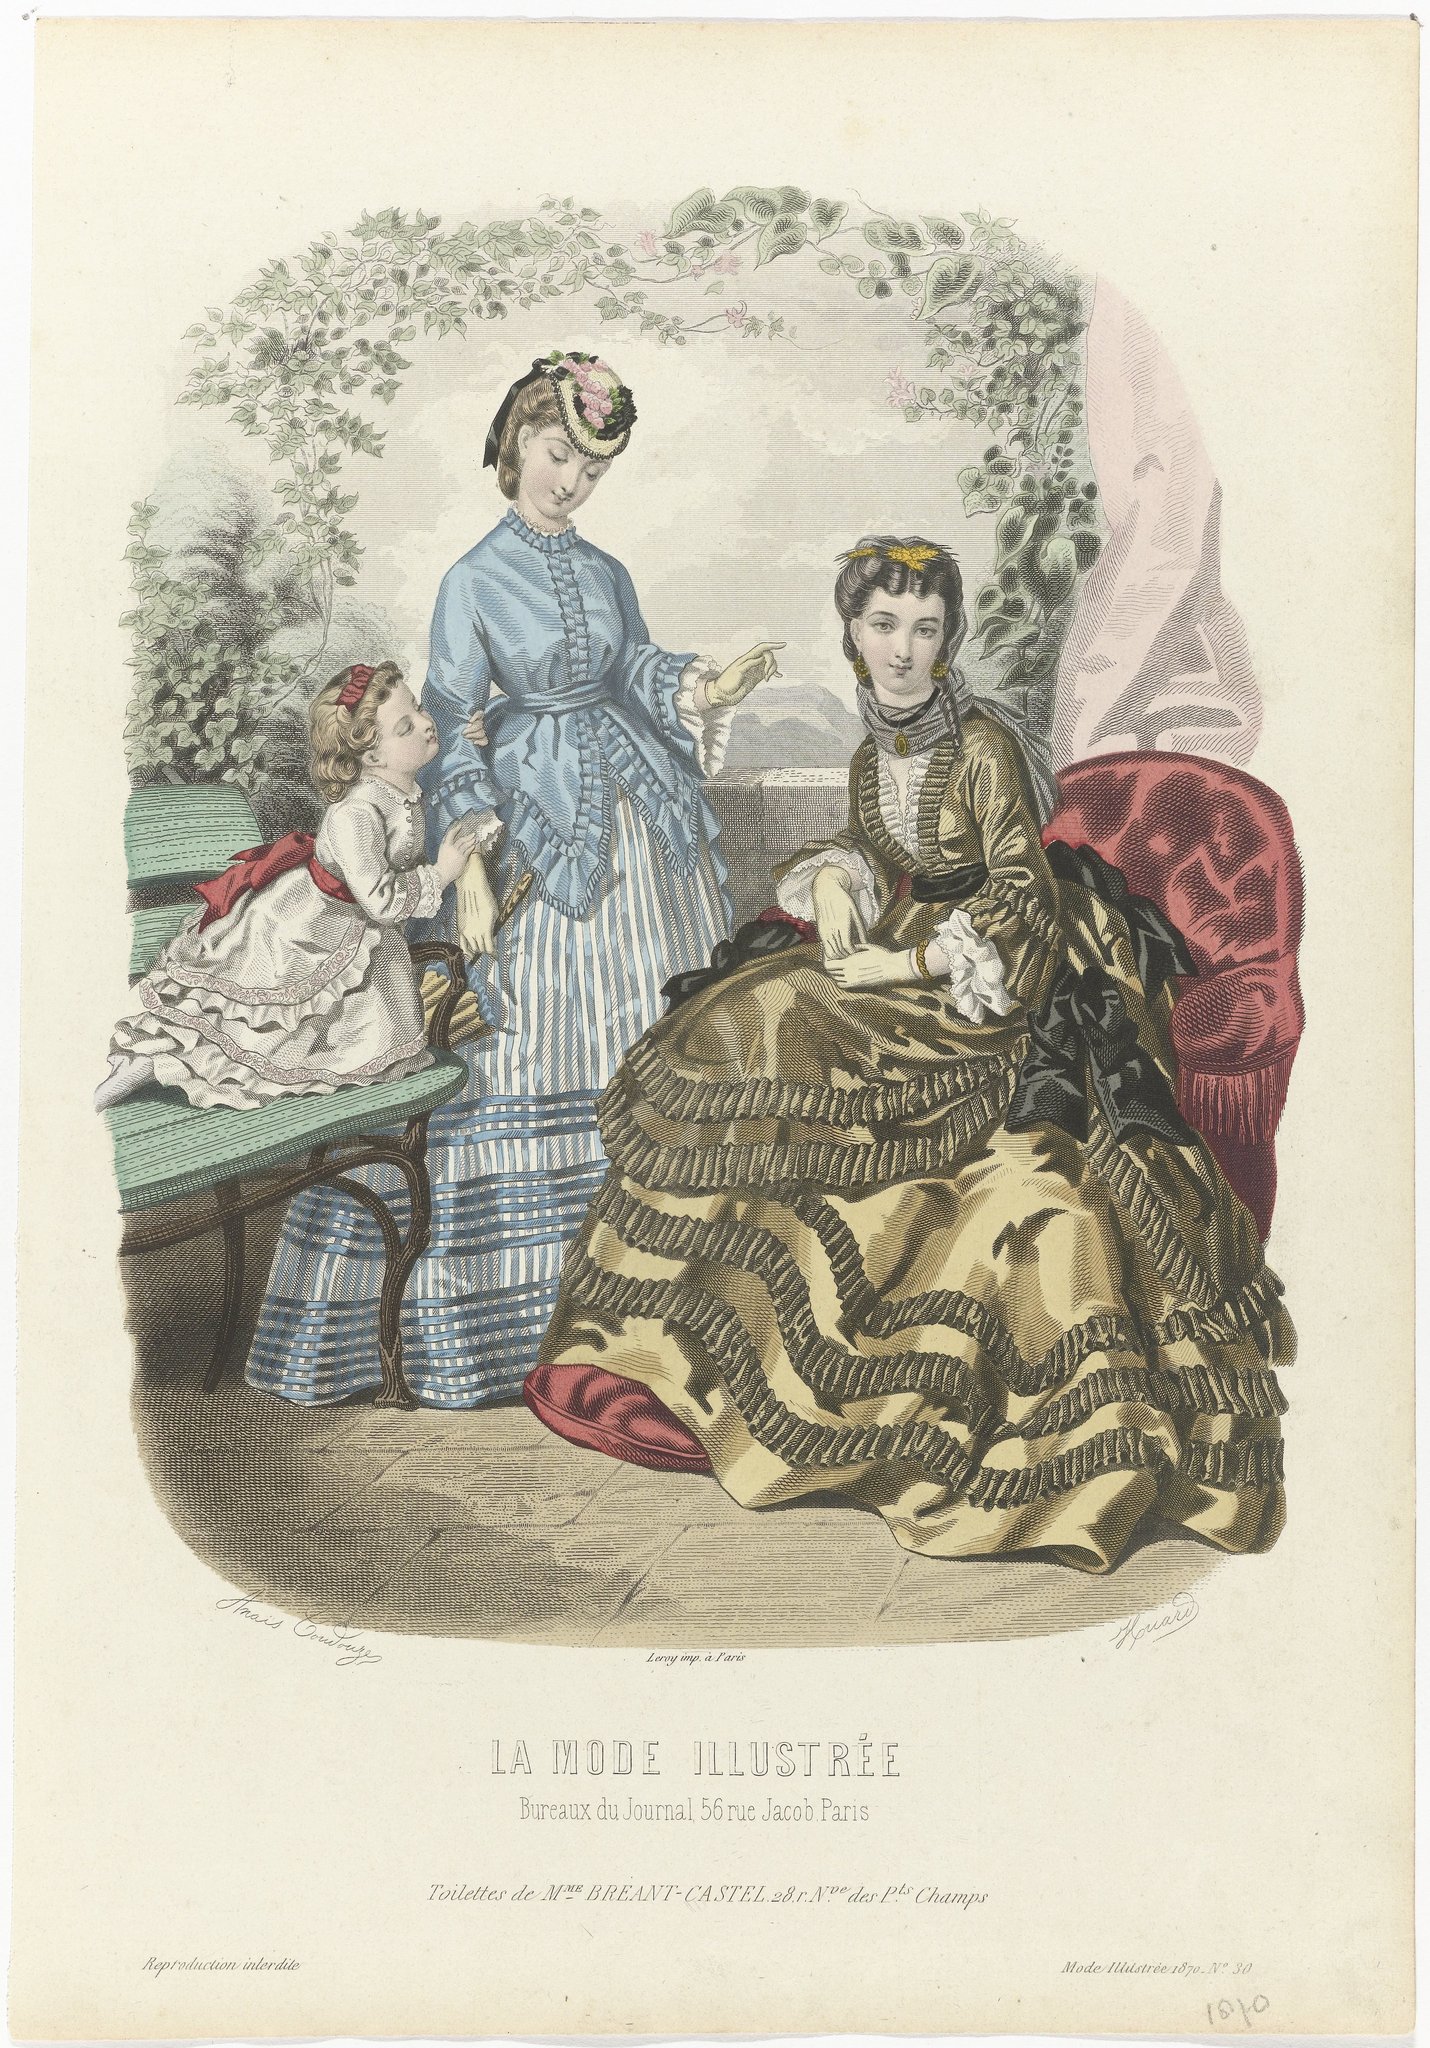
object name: fashion print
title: La Mode Illustrée, 1870, No. 30: Toilettes de Mme Breant-Castel (...)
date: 1870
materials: paper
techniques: engraving, hand coloring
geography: paris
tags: clothing for the upper part of the body (+ women's clothes), pendant, trinket, 'breloque' (+ women's clothes), belt, girdle, waistband (+ girls' clothes), head-gear (+ women's clothes), fashion plates, skirt (+ women's clothes), gloves, mittens, etc. (+ women's clothes), dress, gown (+ women's clothes), bracelet, wristlet (+ women's clothes), parasol, sunshade (+ women's clothes), dress, gown (+ girls' clothes)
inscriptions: caption: ‘Toilettes de Mme Brèant-Castel.28.r.Nve des Pts Champs’, title: ‘La Mode Illustrée’, address: ‘Bureaux du Journal, 56, Rue Jacob. Paris’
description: Twee vrouwen en een kind in een park, gekleed in japonnen van Brèant-Castel. Prent uit het modetijdschrift La Mode Illustrée (1860-1937).